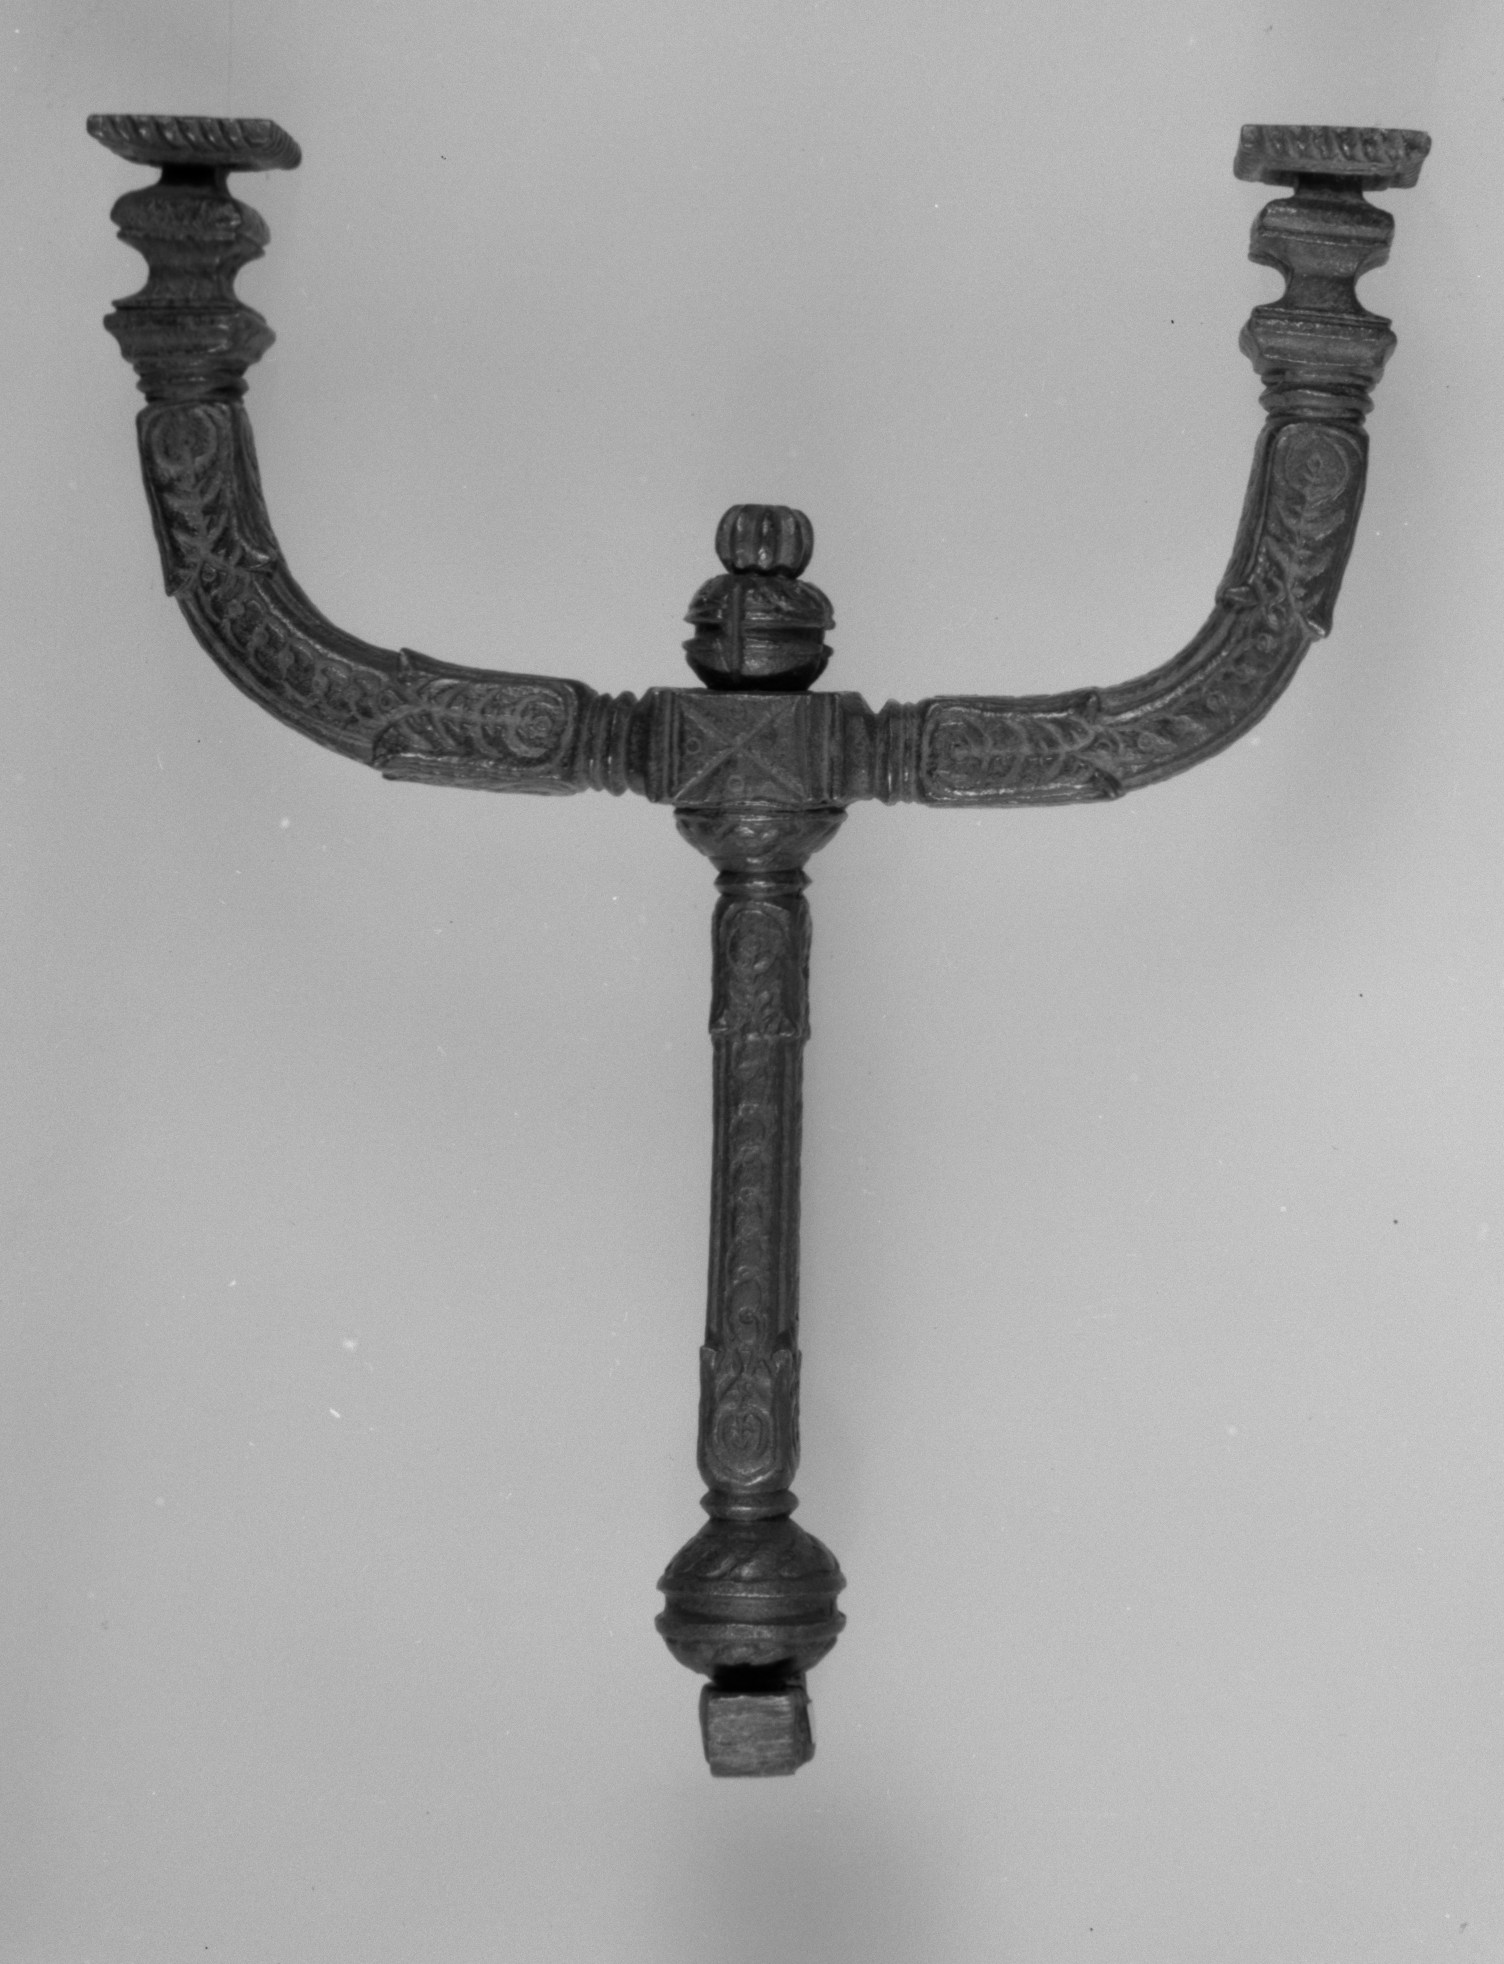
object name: bed leg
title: Bed leg (one of four)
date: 1501-1600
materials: iron